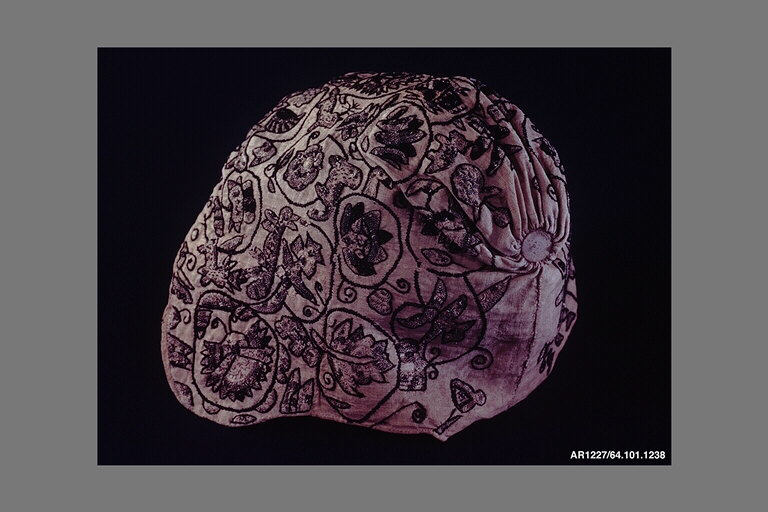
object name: coif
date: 1576-1600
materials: linen, metal thread, silk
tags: flowers